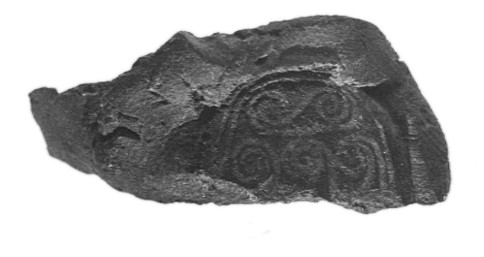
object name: sealing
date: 2030-1640 BCE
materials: clay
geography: egypt